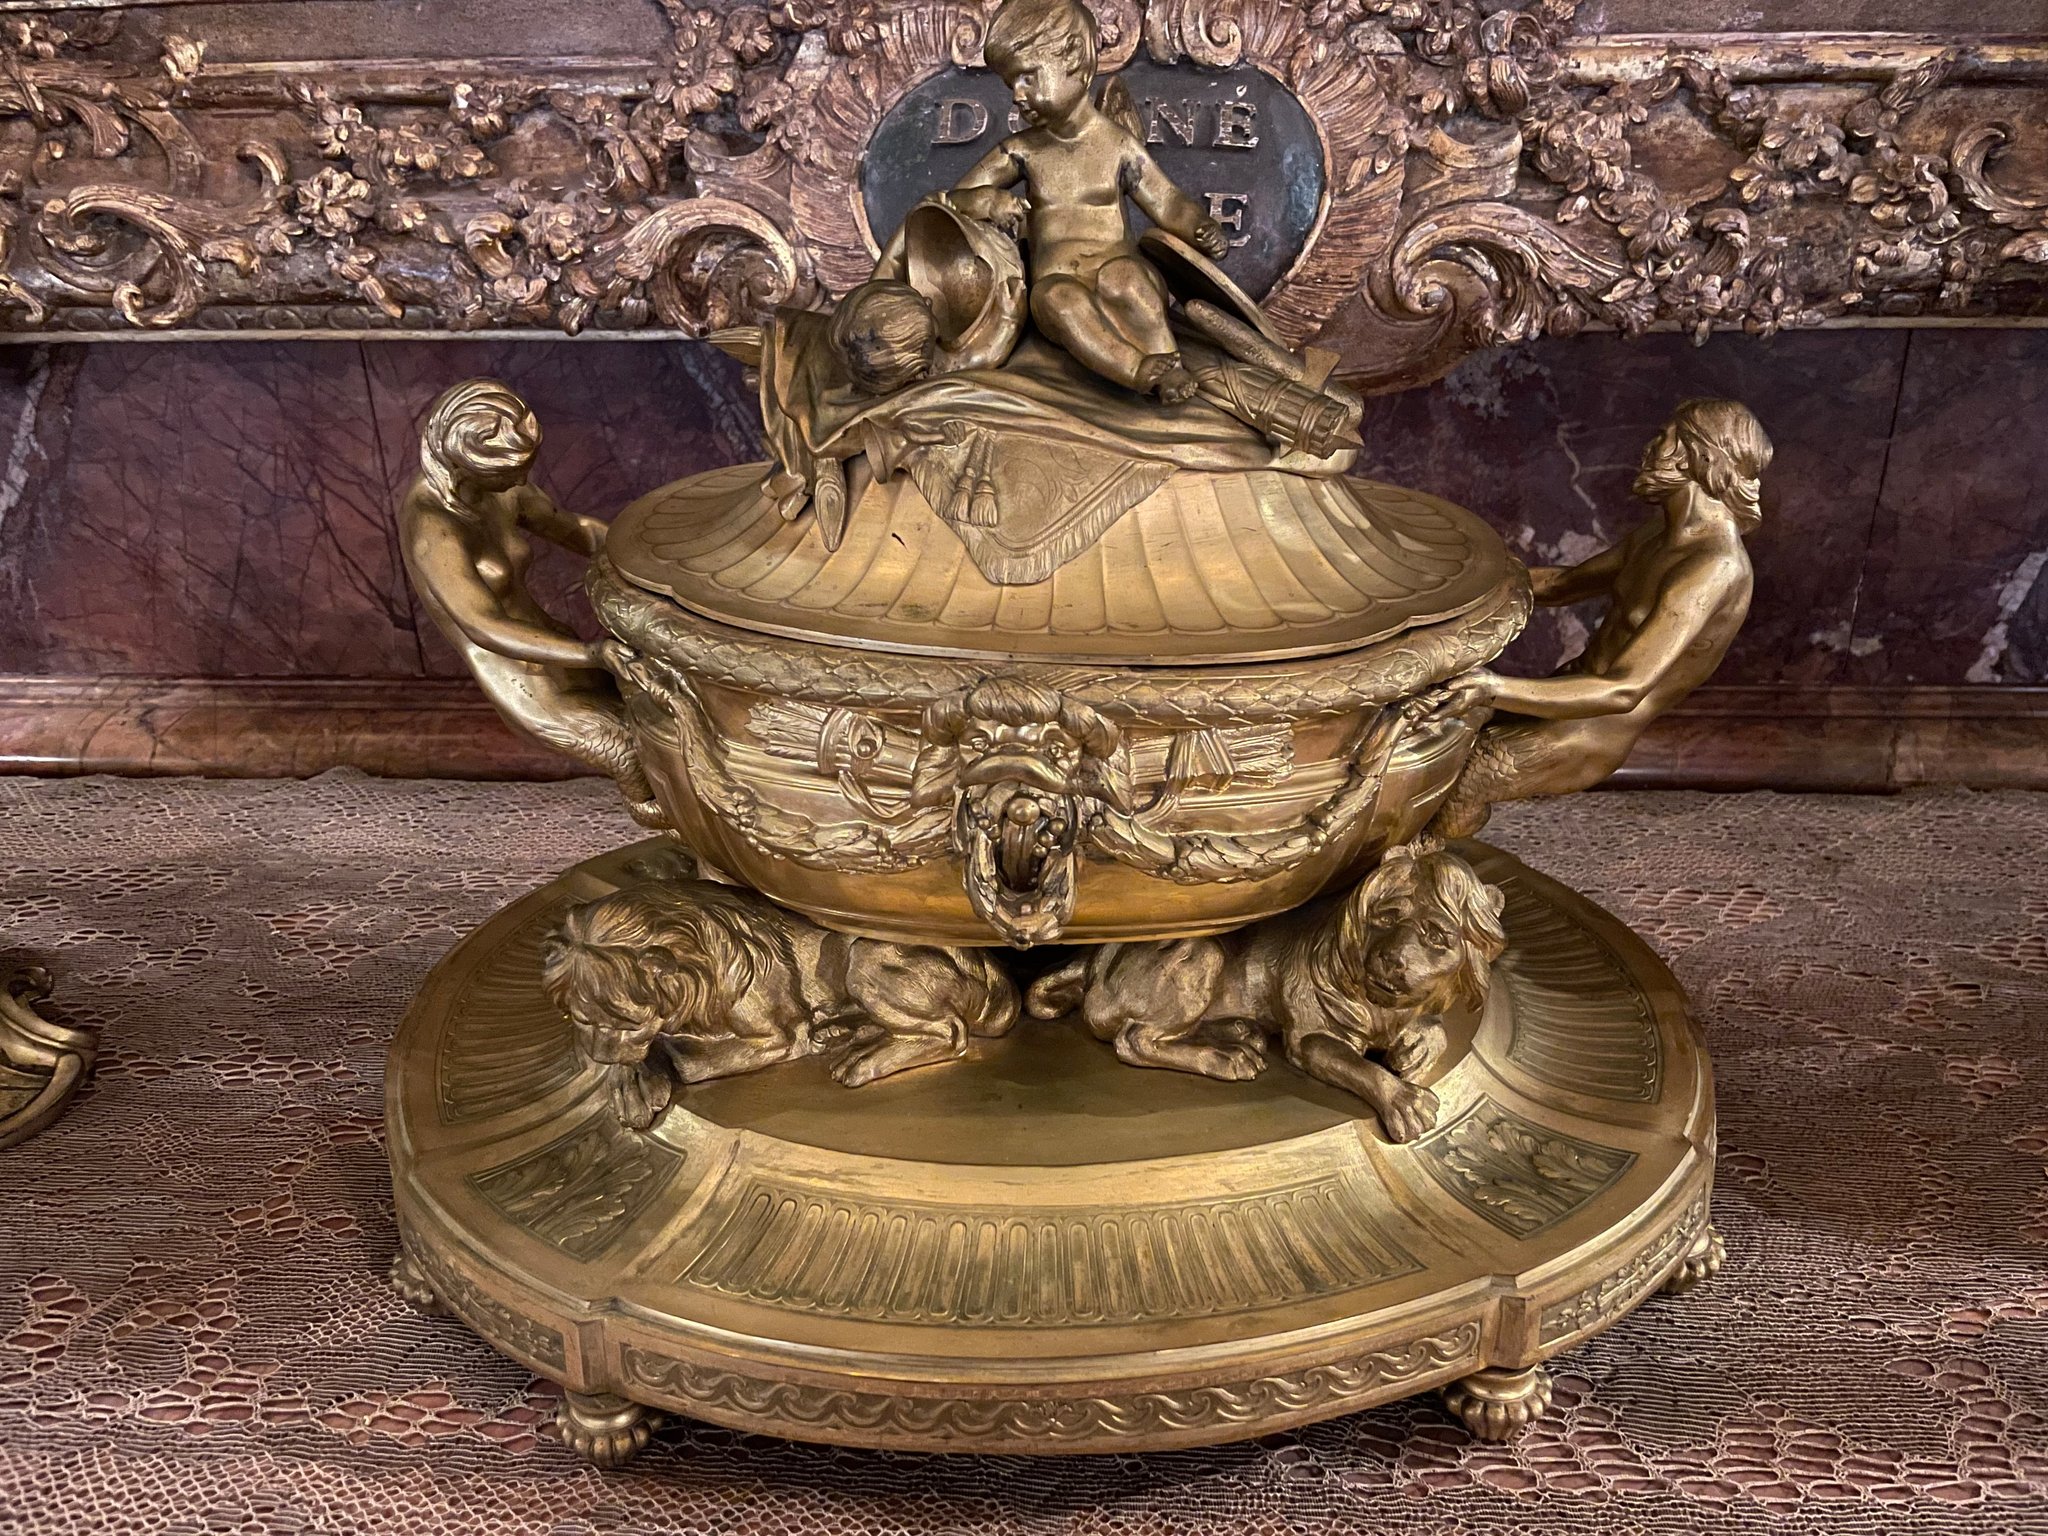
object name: tureen with cover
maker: paul charvel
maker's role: maker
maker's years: 1800-1900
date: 1801-1900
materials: metal, silver